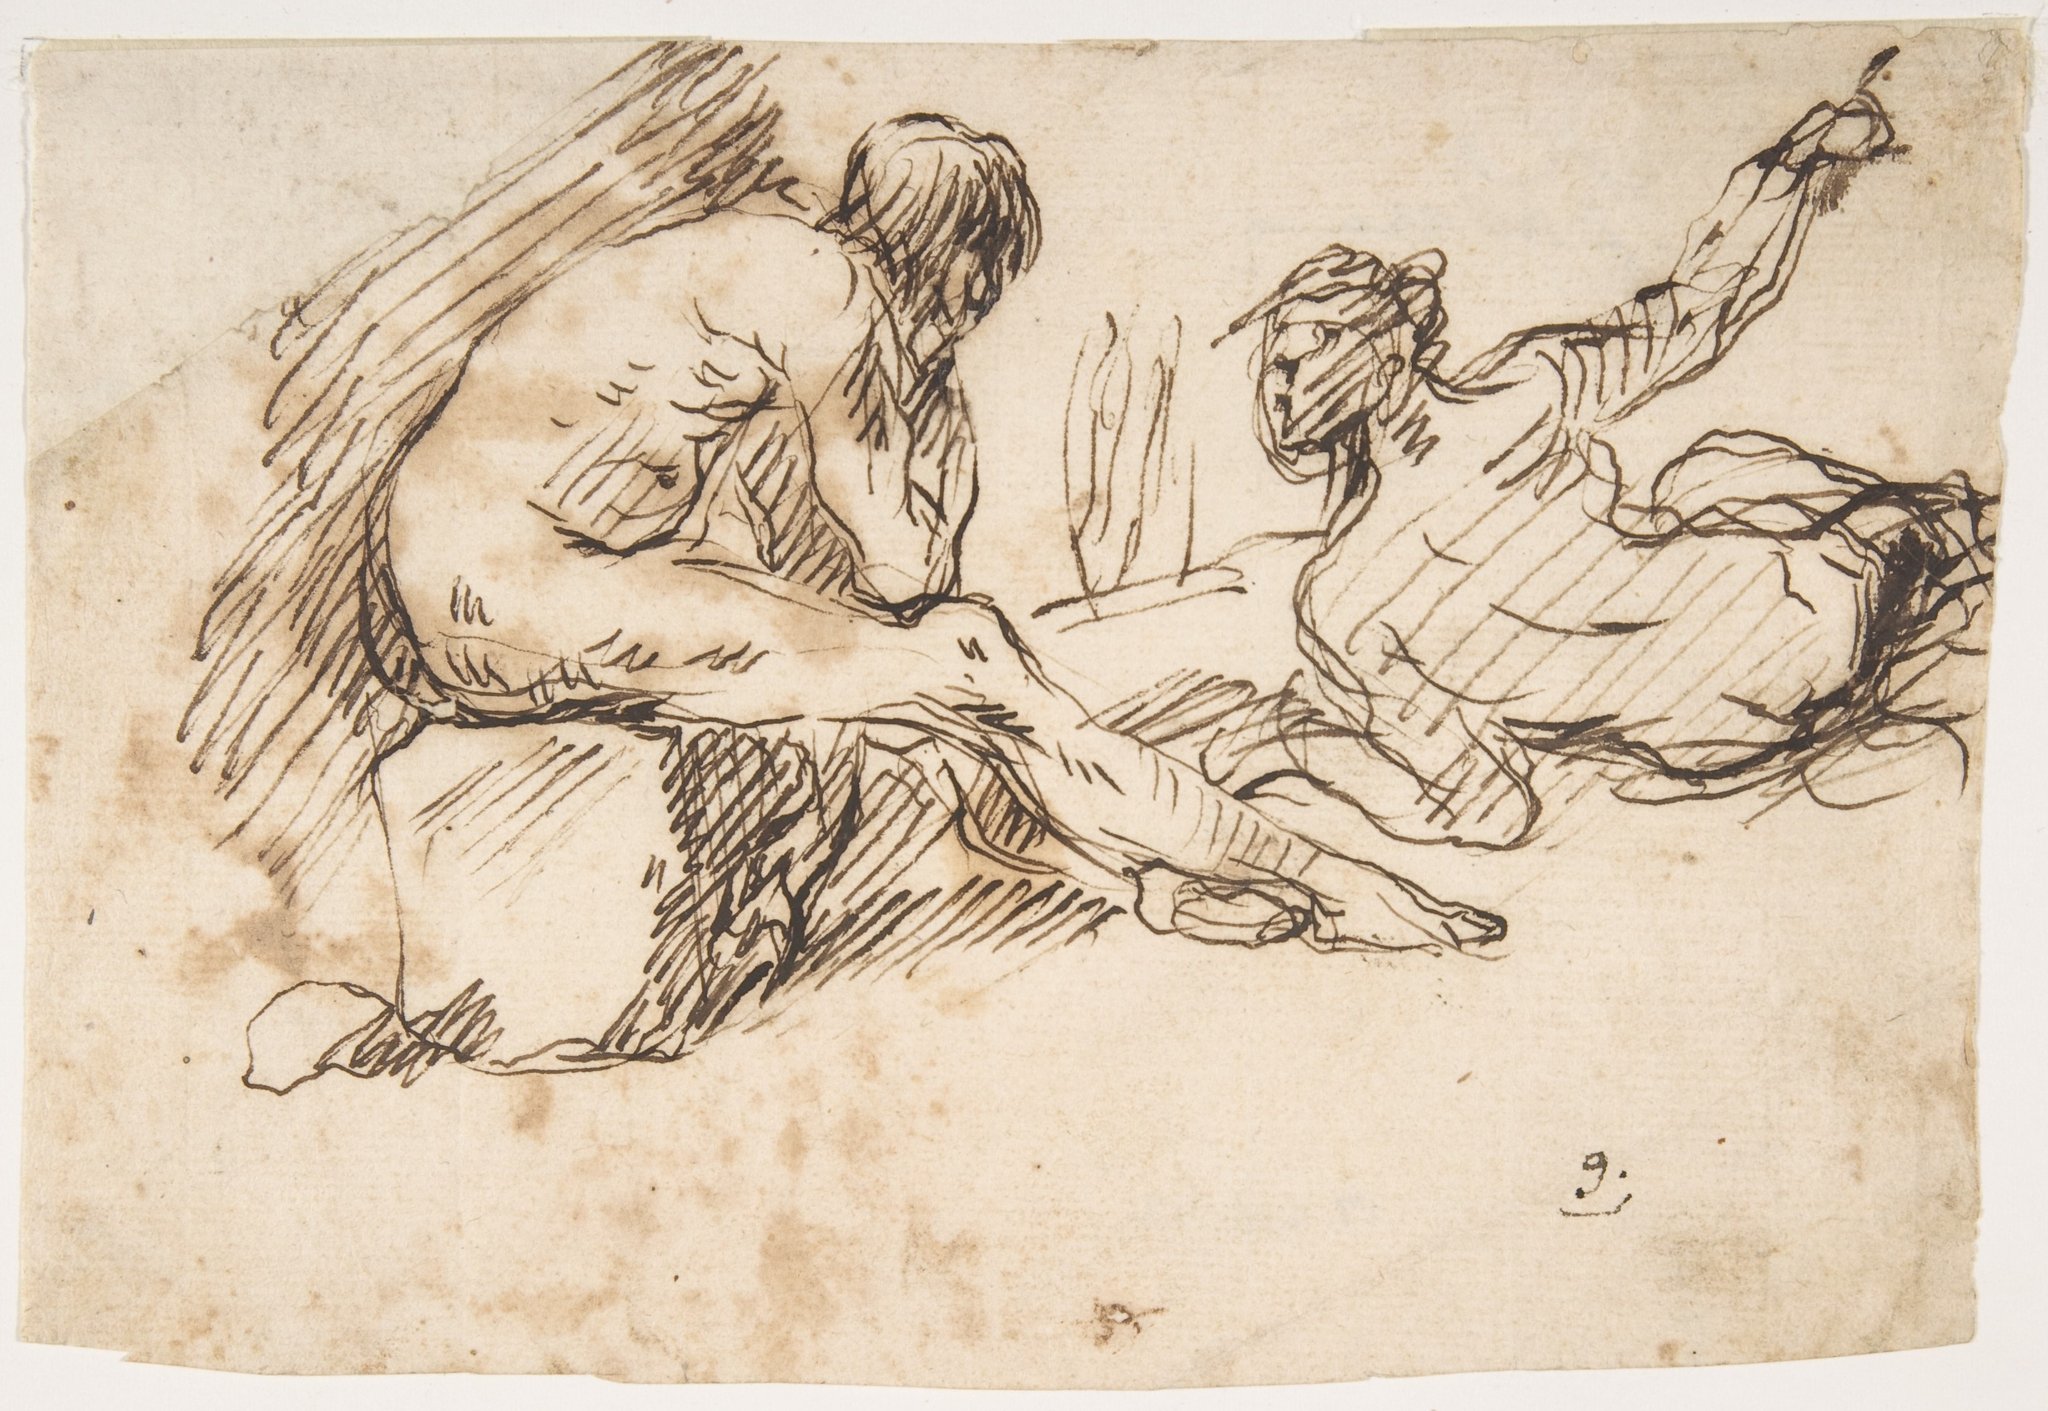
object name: drawing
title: Two Nude Male Figures, One Seated and One Reclining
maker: micco spadaro (domenico gargiulo)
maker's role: artist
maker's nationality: italian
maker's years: 1609-1675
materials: ink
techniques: pen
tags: male nudes